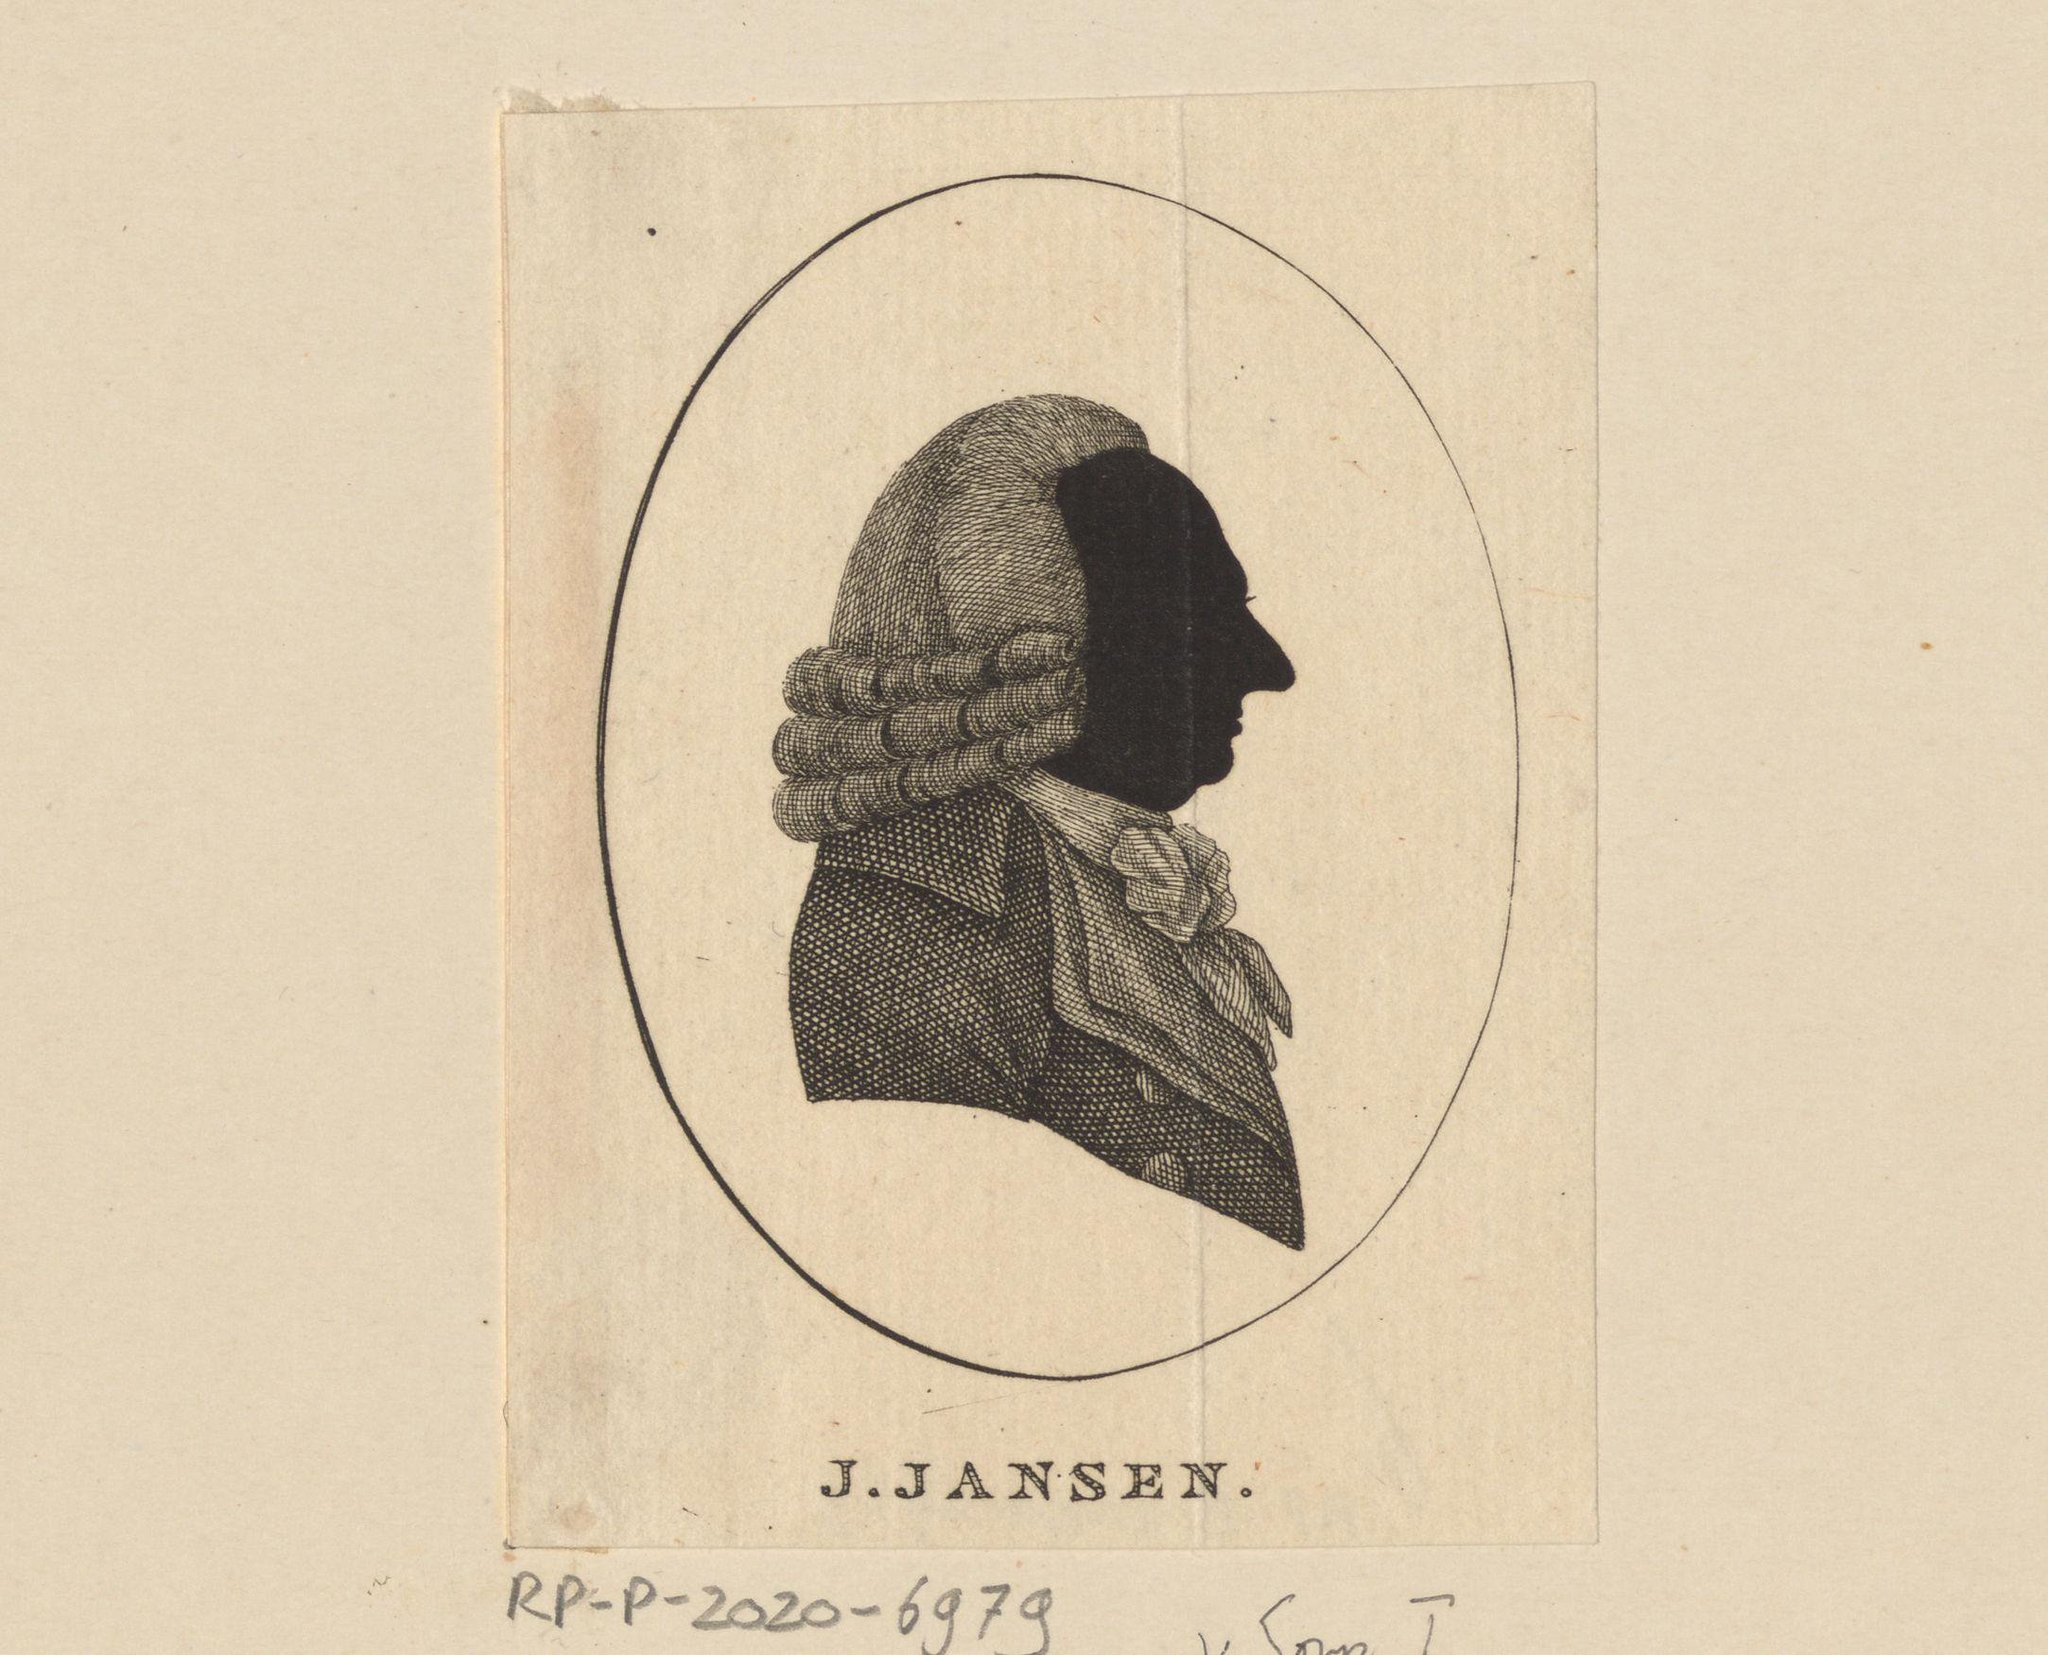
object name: print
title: Silhouetportret van Jacobus Jansen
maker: Anonymous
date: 1799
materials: paper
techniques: etching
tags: historical persons, functionaries and dignitaries ~ protestant churches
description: Deze prent maakt mogelijk deel uit van een grotere prent die later is verknipt. Prent waarschijnlijk uit: Rogge, Cornelius. Geschiedenis der staatsregeling, voor het Bataafsche volk. Amsterdam: Johannes Allart, 1799.